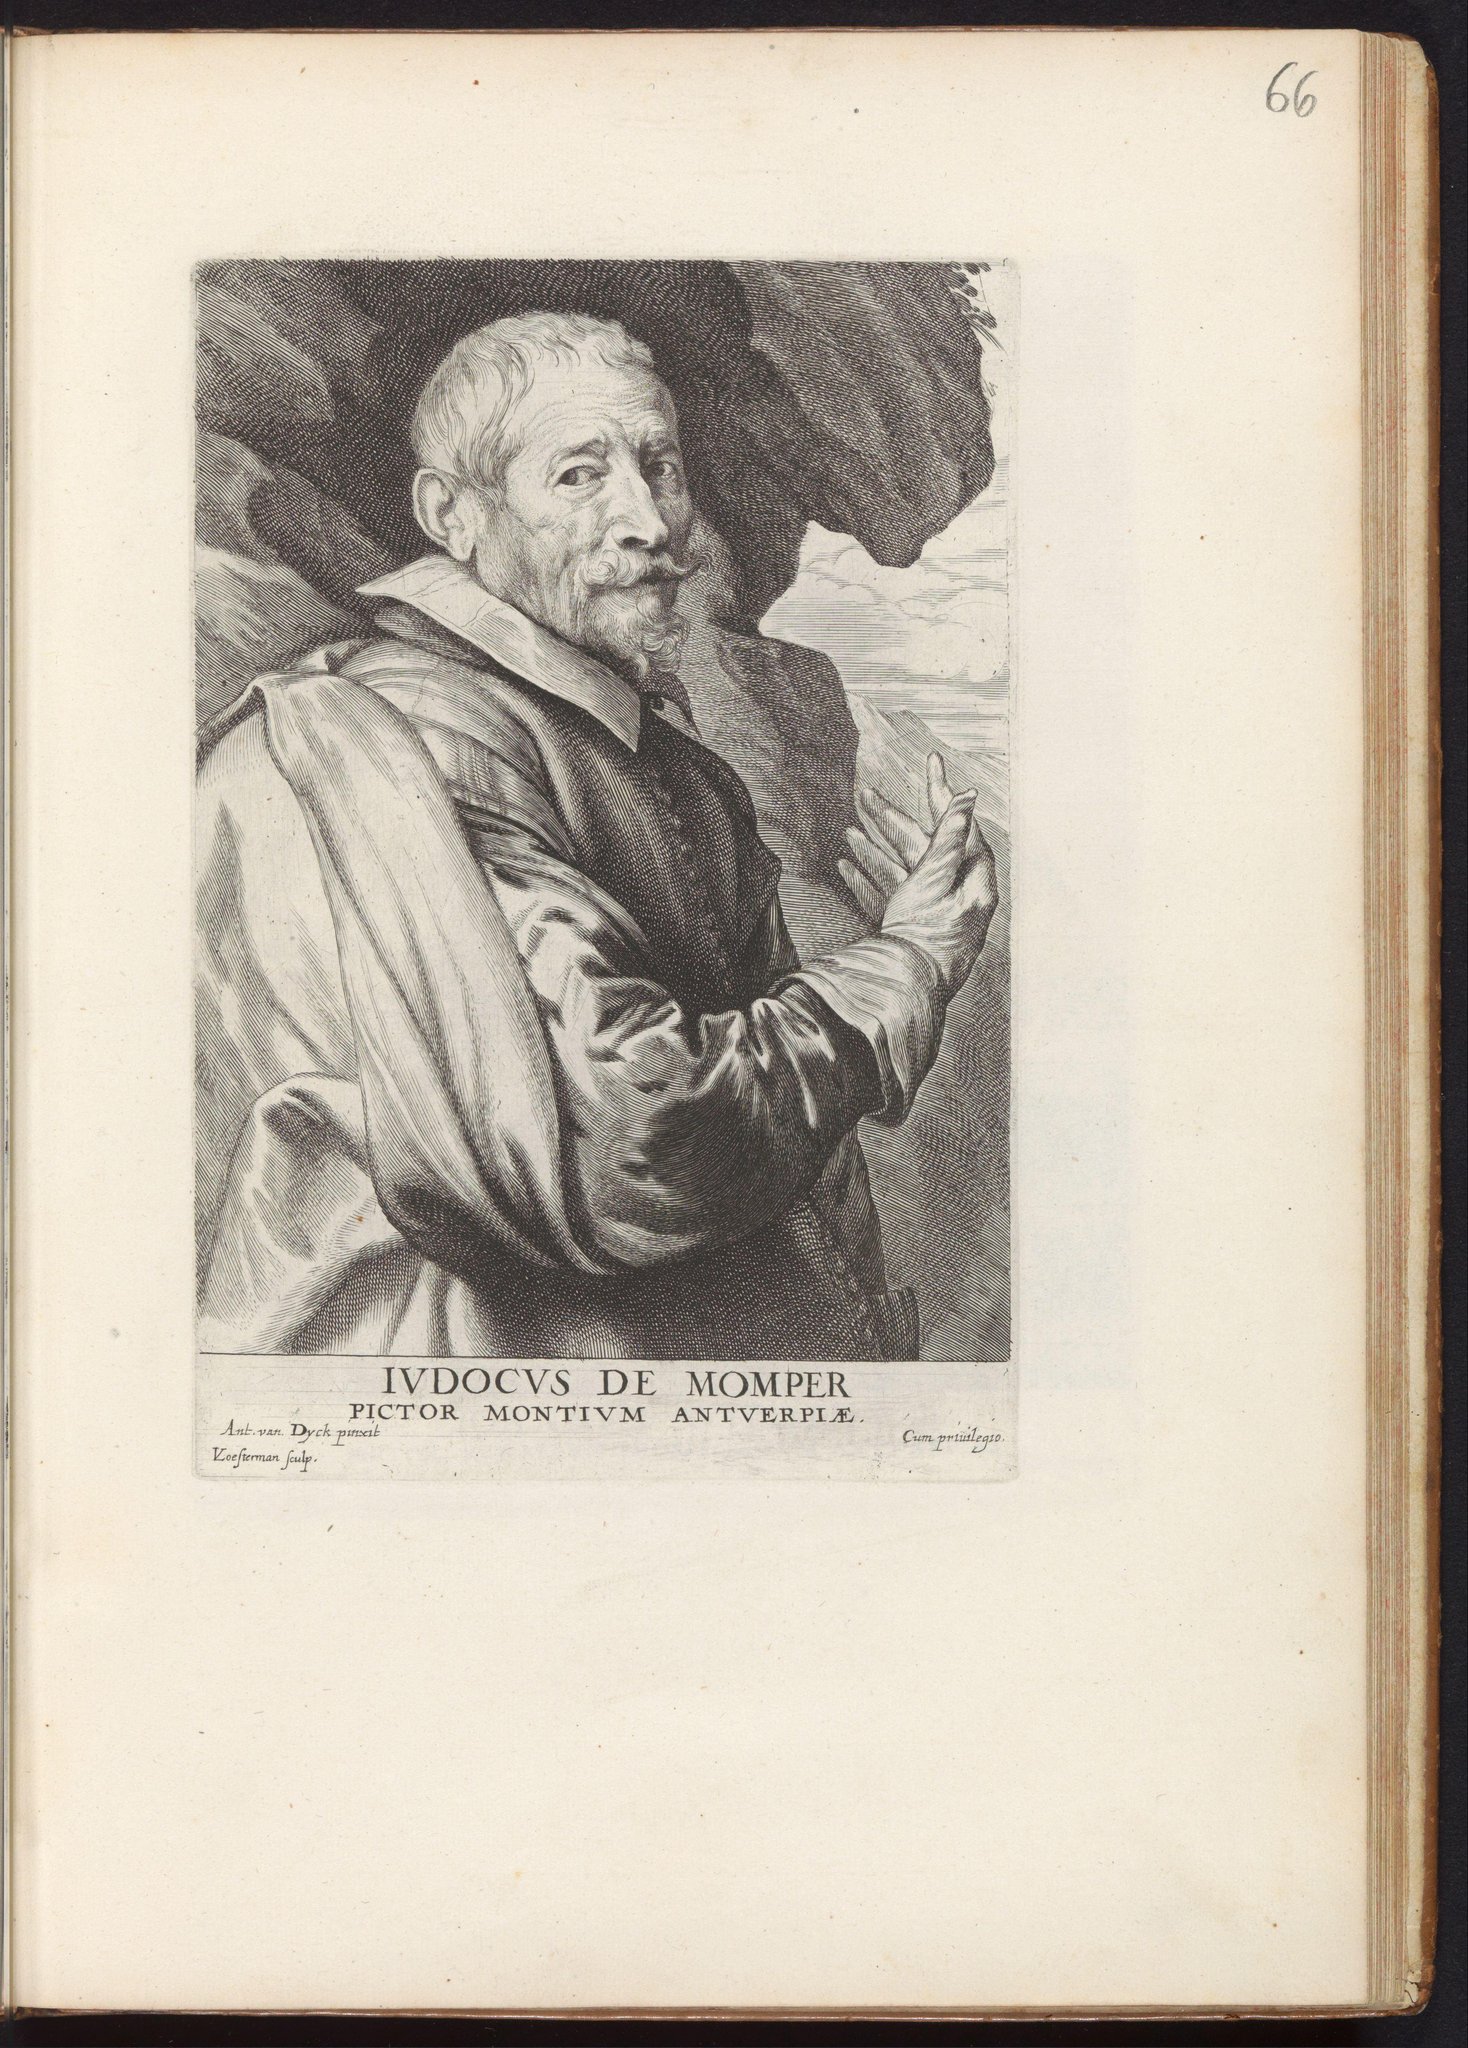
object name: print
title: Iconographie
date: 1630-1641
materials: paper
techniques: engraving, etching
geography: antwerp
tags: antwerp, painter, draughtsman, joos de momper (ii), portrait, self-portrait of painter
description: Deze prent maakt deel uit van een album.